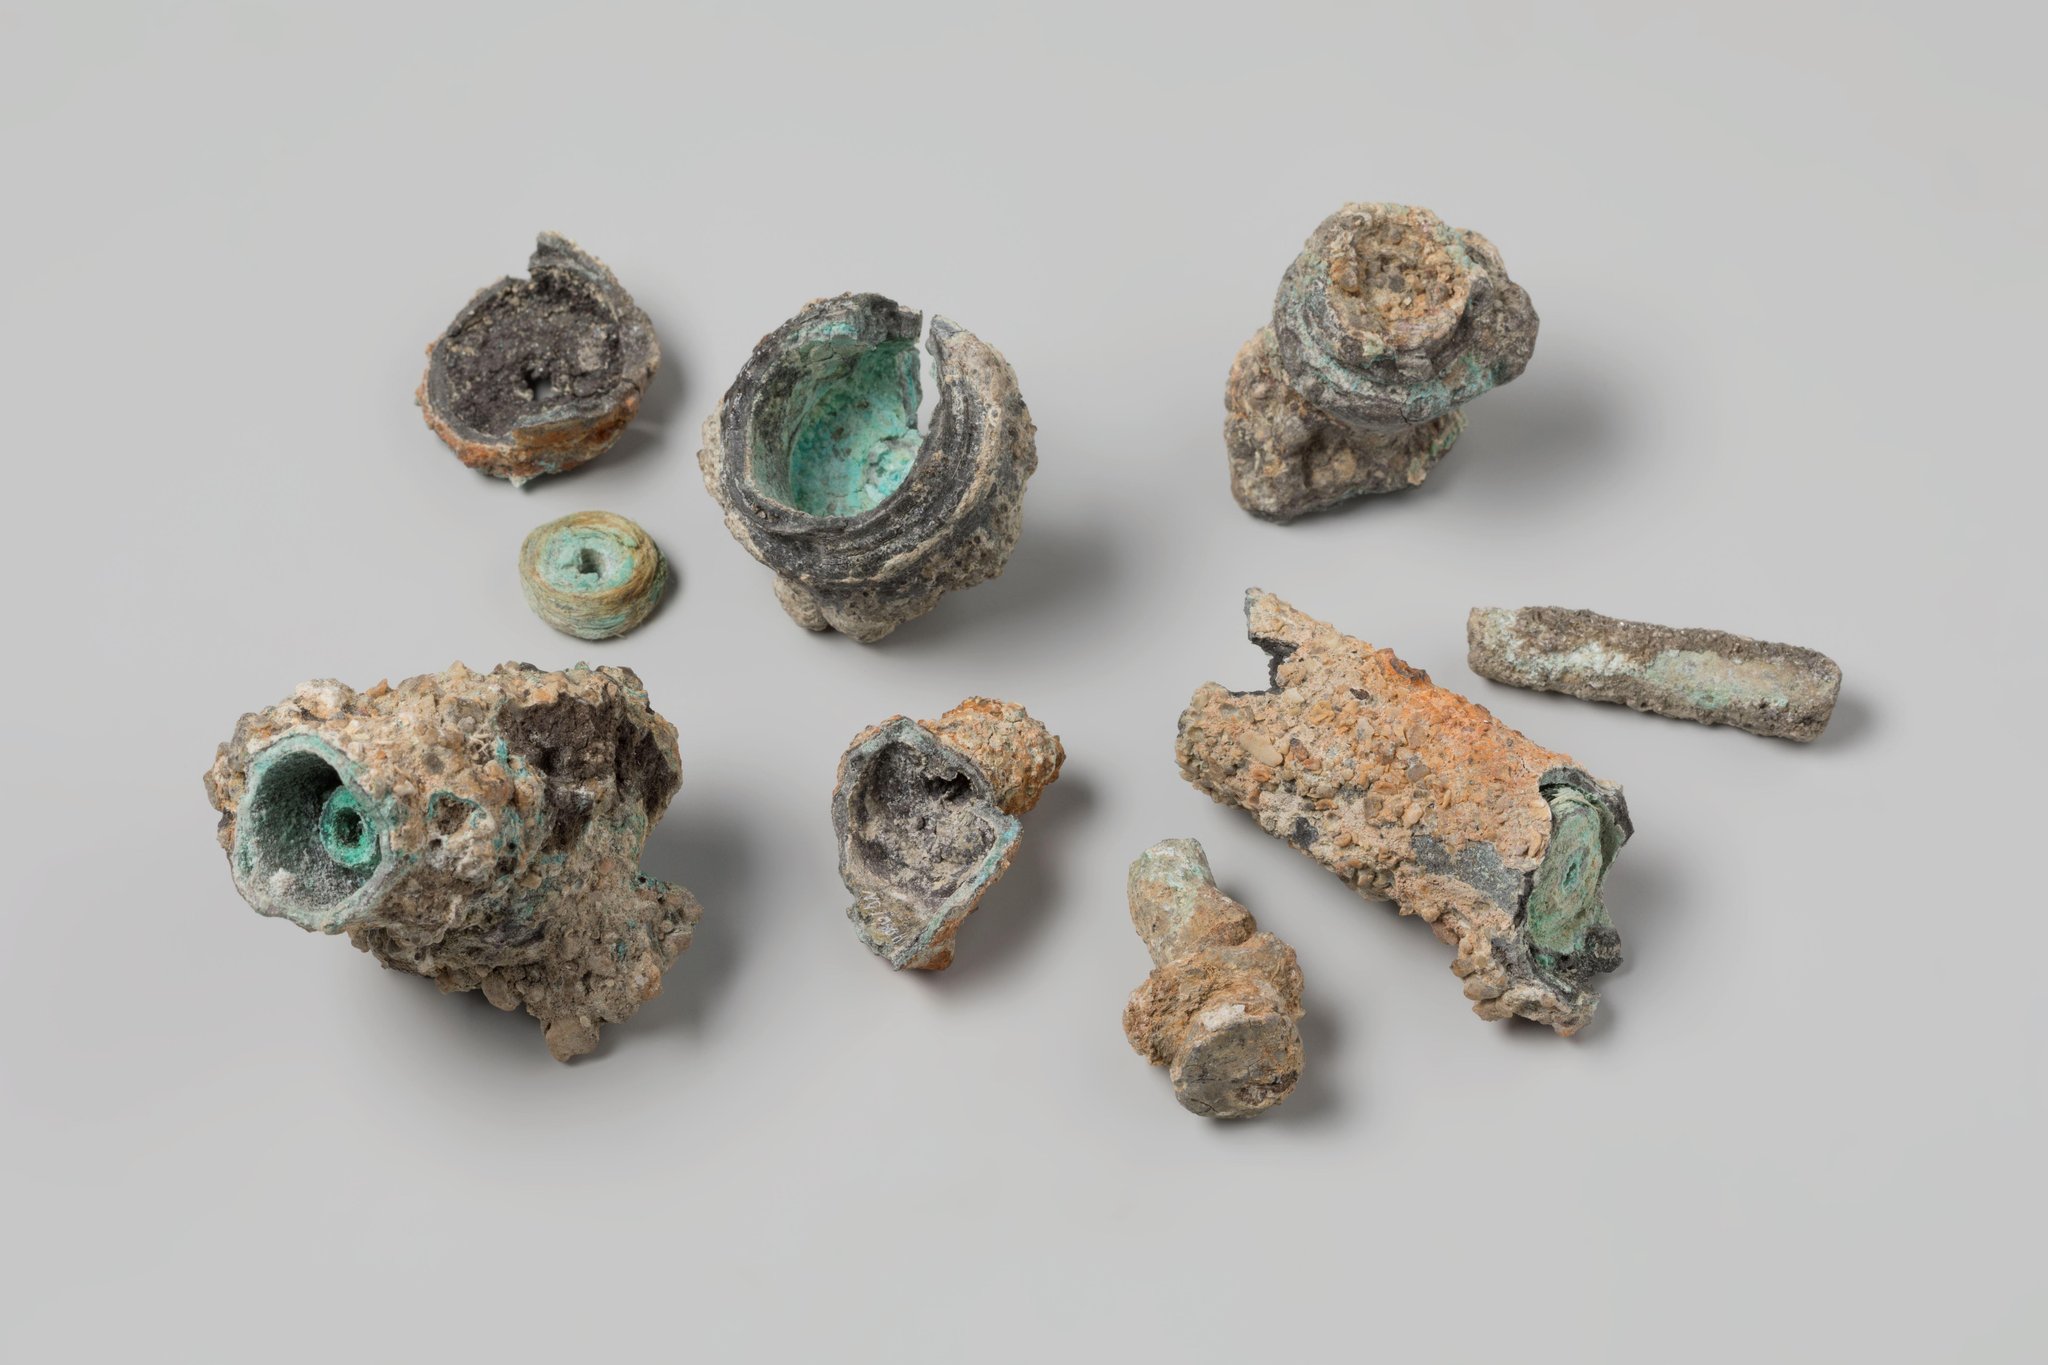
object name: enema syringe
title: Klisteerspuit uit het wrak van de Oost-Indiëvaarder Hollandia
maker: Anonymous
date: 1700-1743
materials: tin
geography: netherlands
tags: verenigde oostindische compagnie, hollandia (schip), annet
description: Tools and instruments, medical, enema syringe; fragm of cylinder and pump system, extremely corroded: ffragm of upper end, circular, moulded rim, flat with fragm of shaft protruding, broken off (moulding 3.2d): (1)fragm of straight cylinder, broken, with piston inside sim. NG 1980-27H1456: fragm of lower end, circular, flanged, externally threaded rim with central hollow shaft: fragm of tube, sim. NG 1980-27H1632/1799.